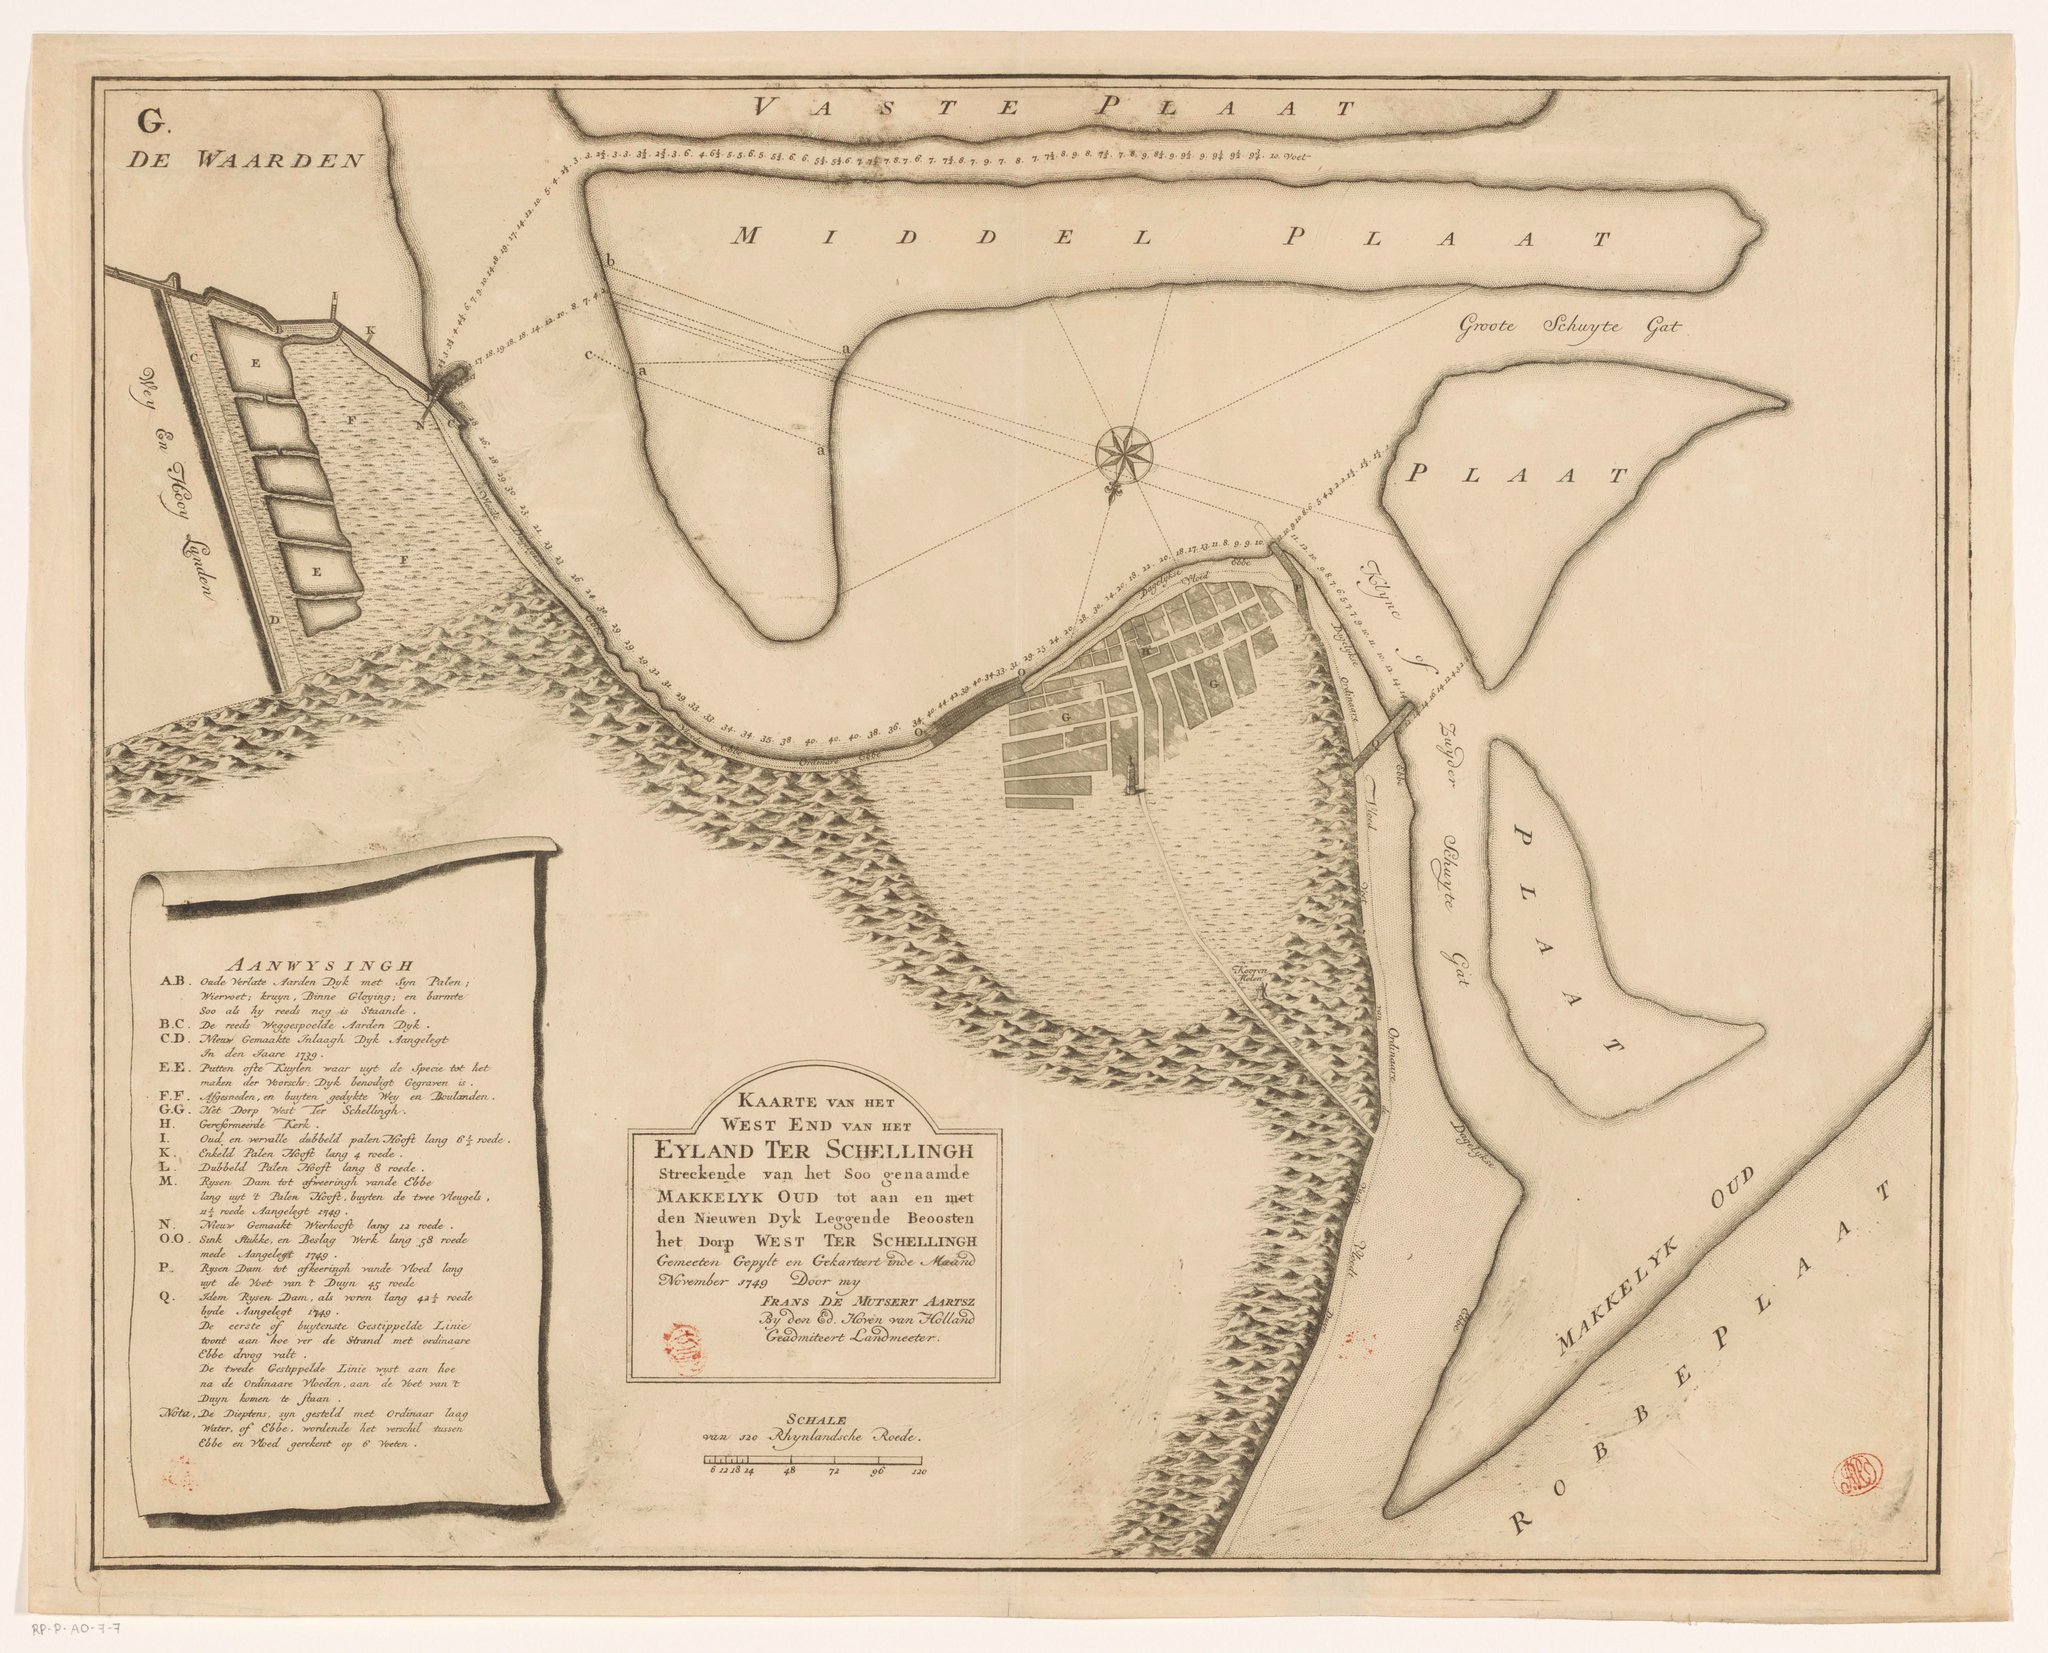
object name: map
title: Kaart van West-Terschelling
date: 1711-1749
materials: paper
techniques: engraving, etching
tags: maps of separate countries or regions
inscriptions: collector's mark: Lugt 195, collector's mark: Lugt 195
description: Links de legenda, rechts daarvan de titelcartouche en daaronder een schaalstok: Schale van 120 Rhynlandsche roede.